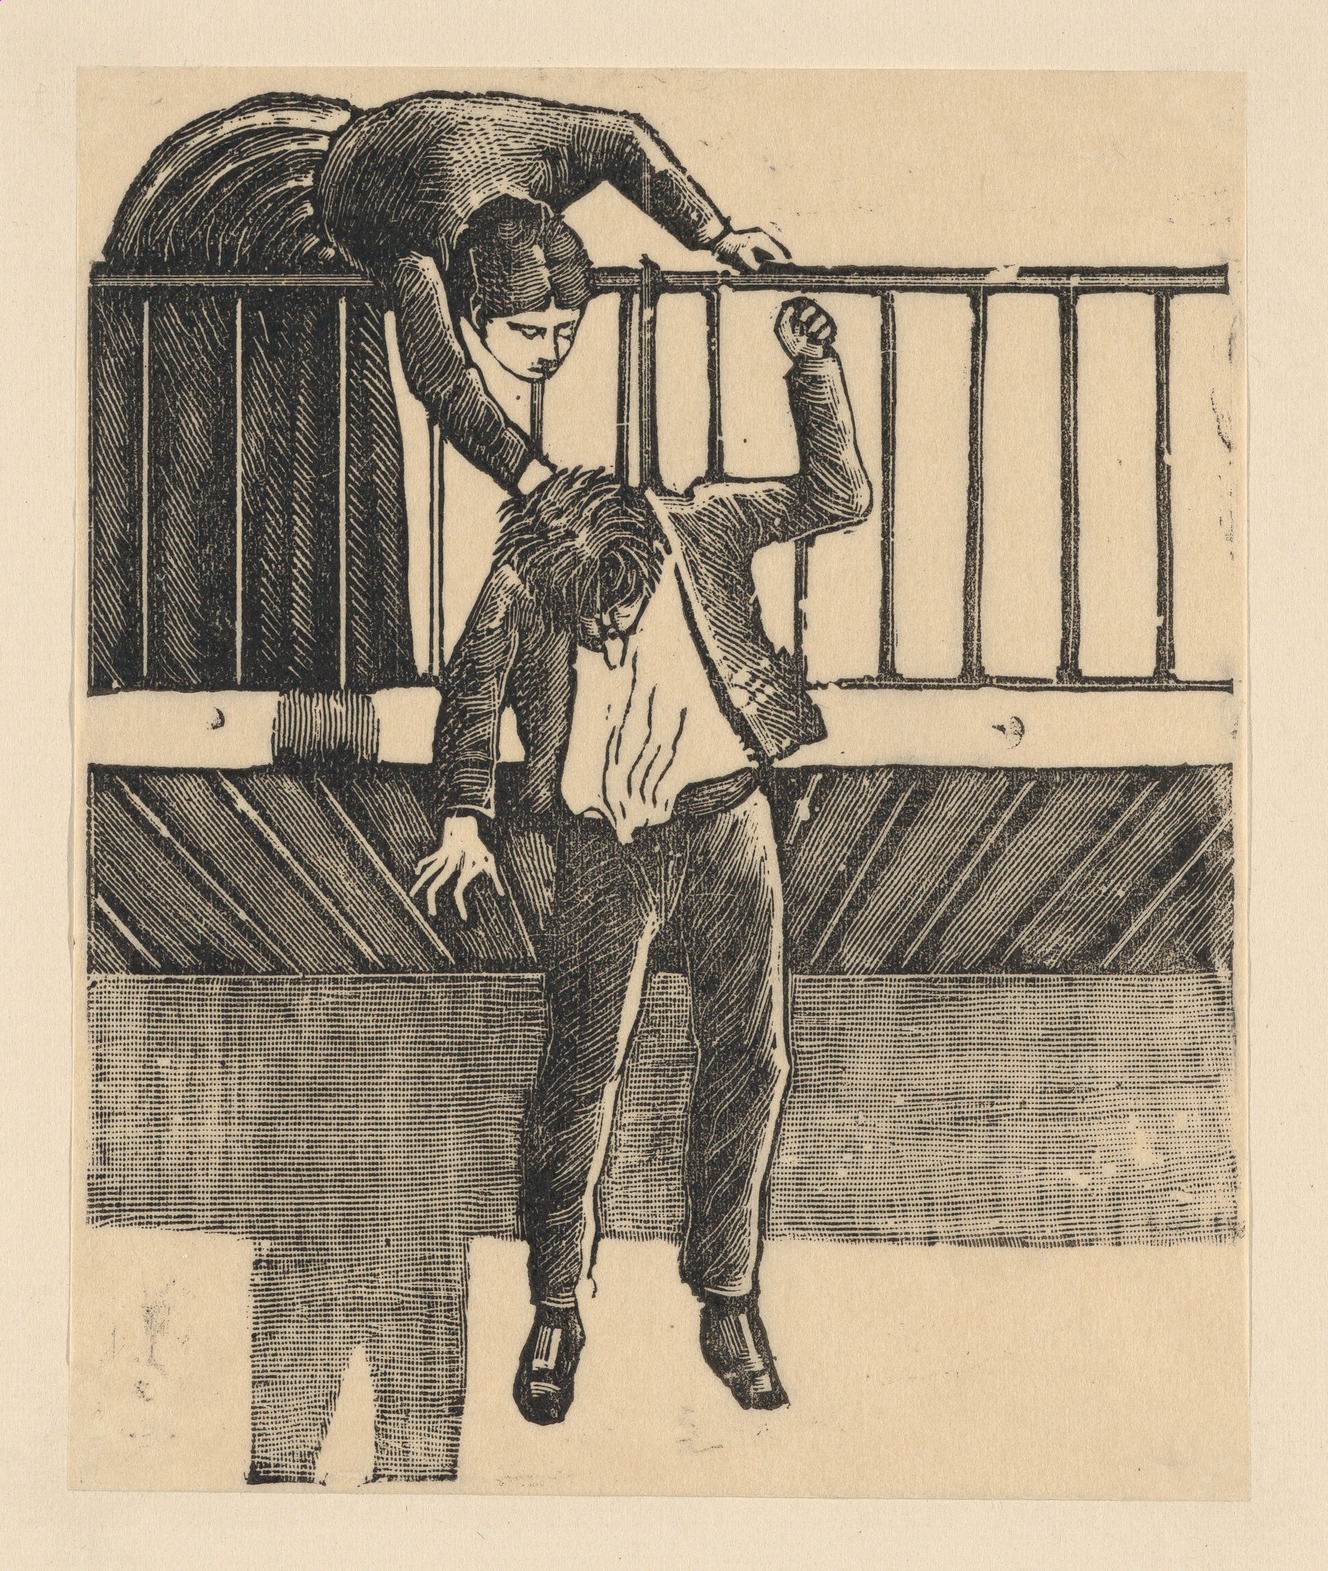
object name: print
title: A woman discovering a man who has committed suicide by hanging himself from a balcony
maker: josé guadalupe posada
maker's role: artist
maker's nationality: mexican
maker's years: 1852-1913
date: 1892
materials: metal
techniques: engraving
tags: balconies,men,women